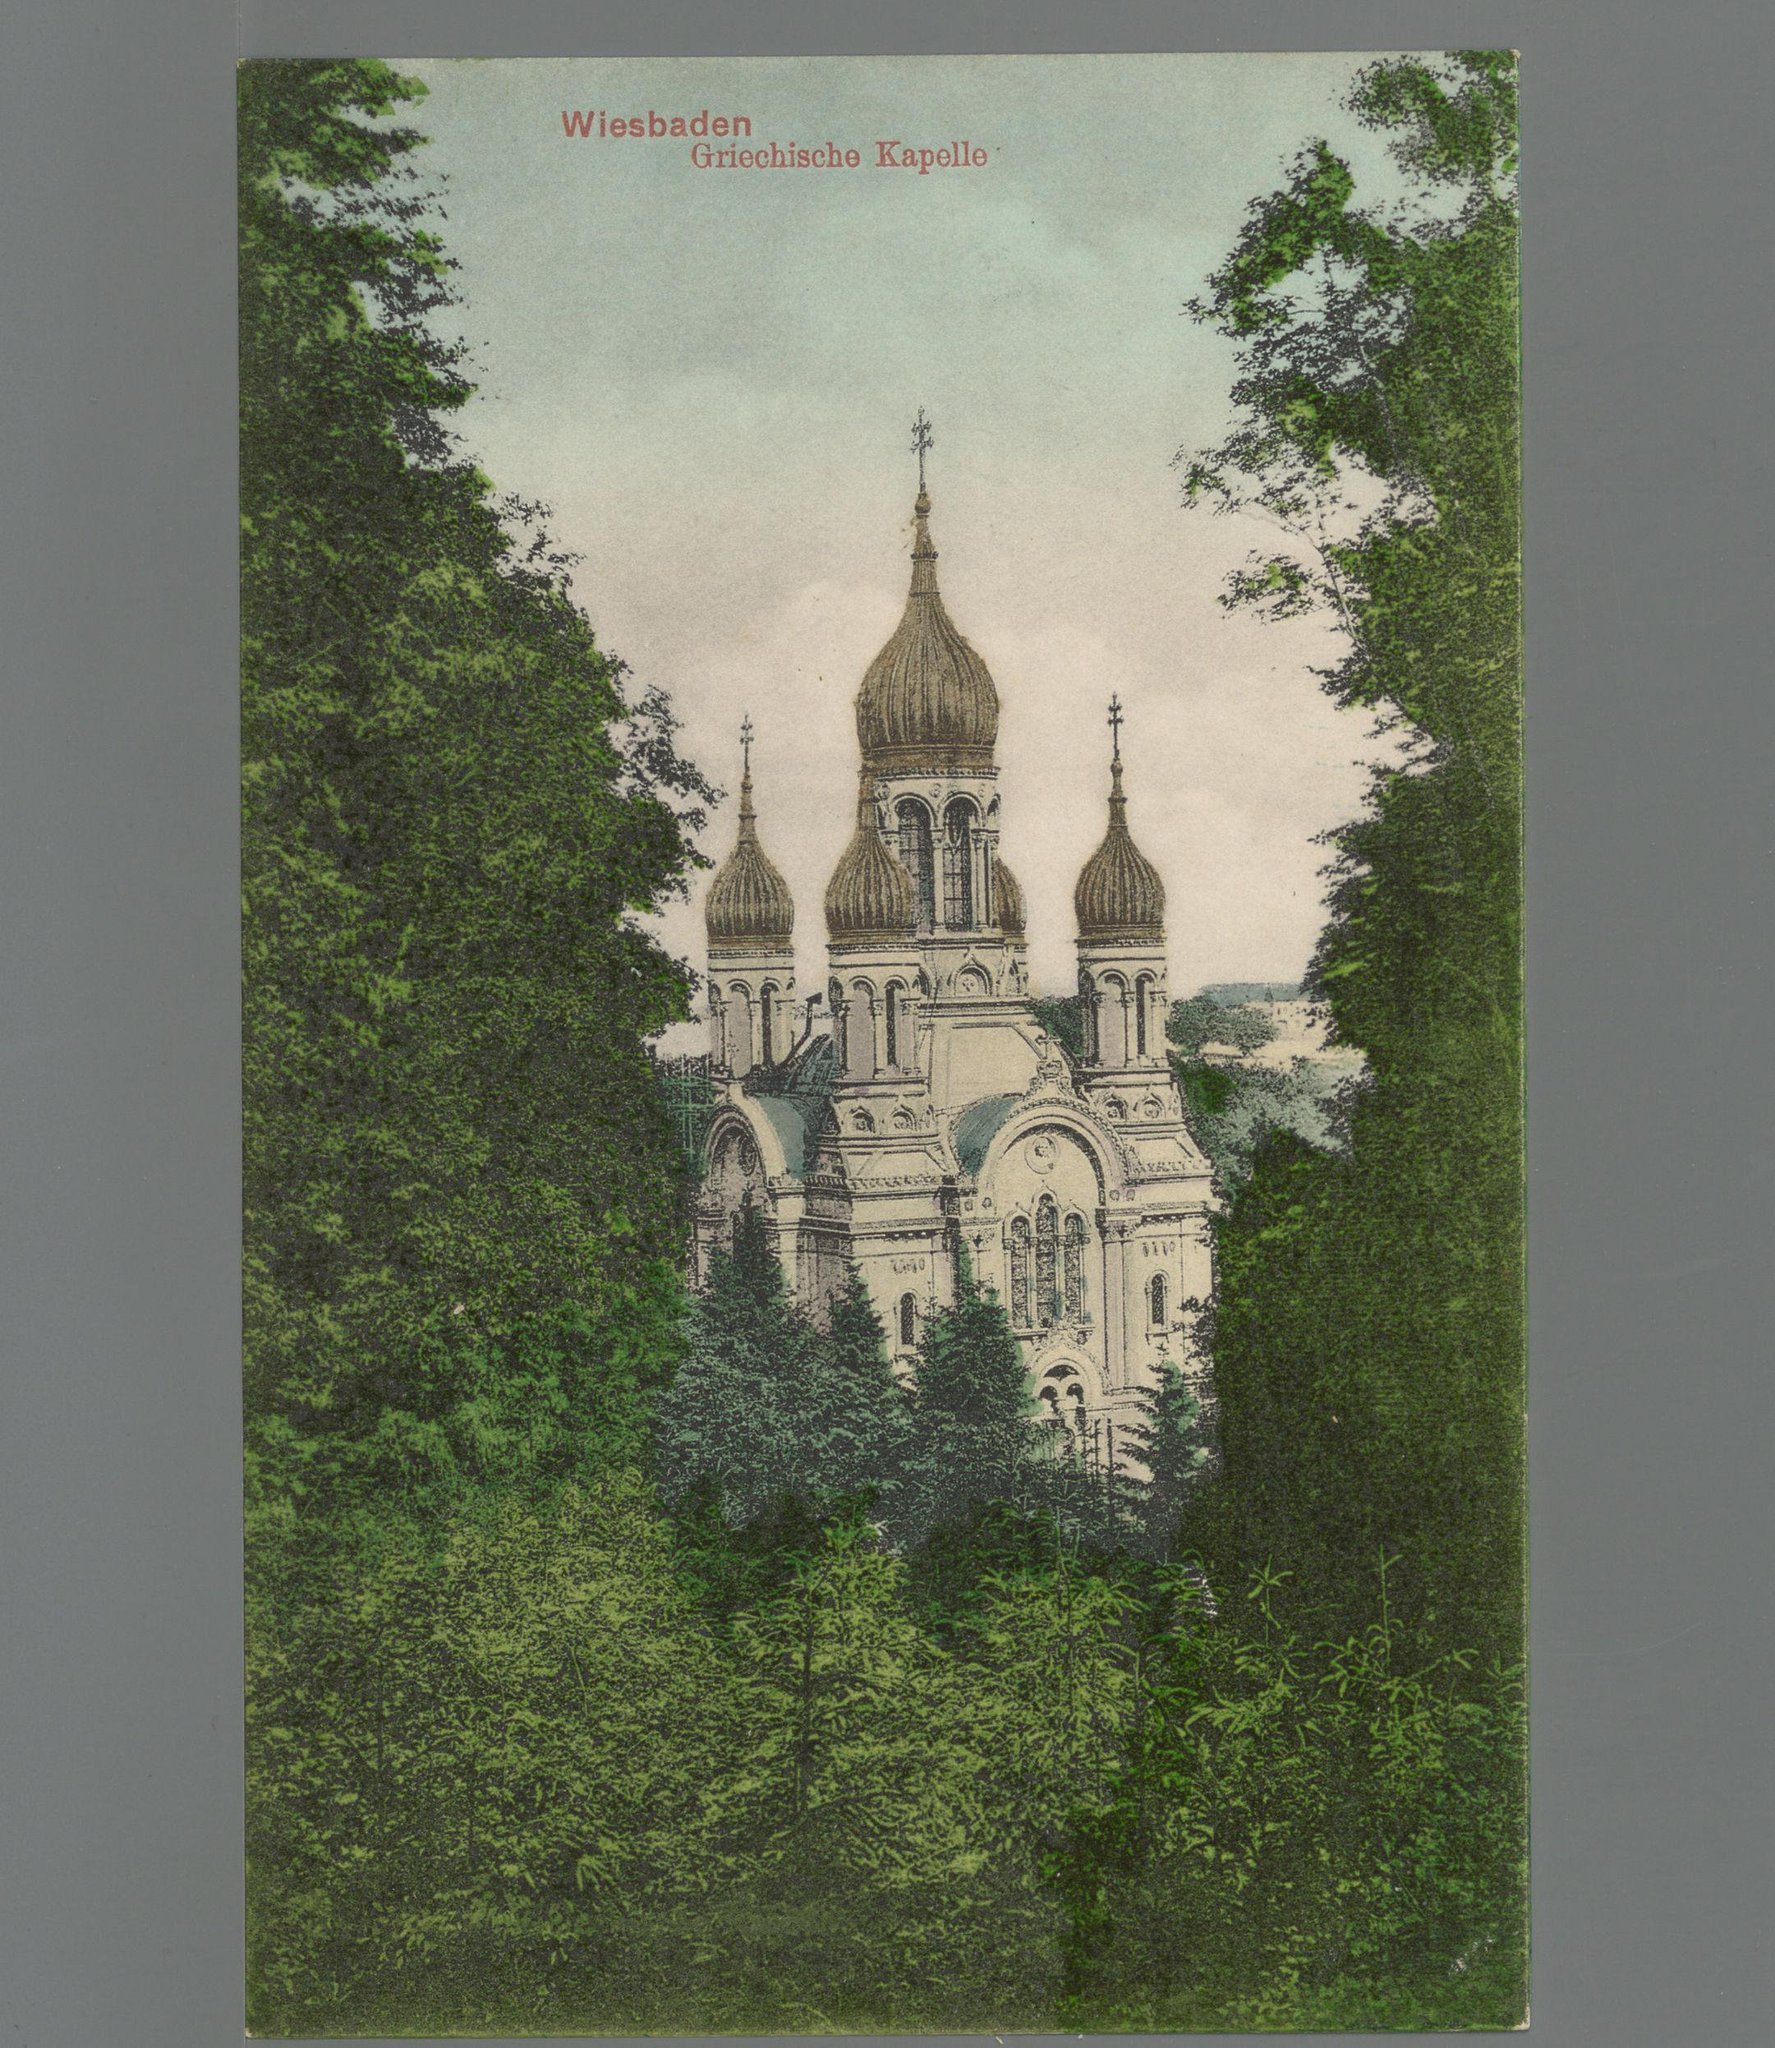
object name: ansichtkaart, prentbriefkaart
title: Wiesbaden Griechische Kapelle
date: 1905-1930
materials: photographic support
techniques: photograph, lithograph, writing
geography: wiesbaden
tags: parts of church exterior and annexes: chapel - qq - small church, chapel